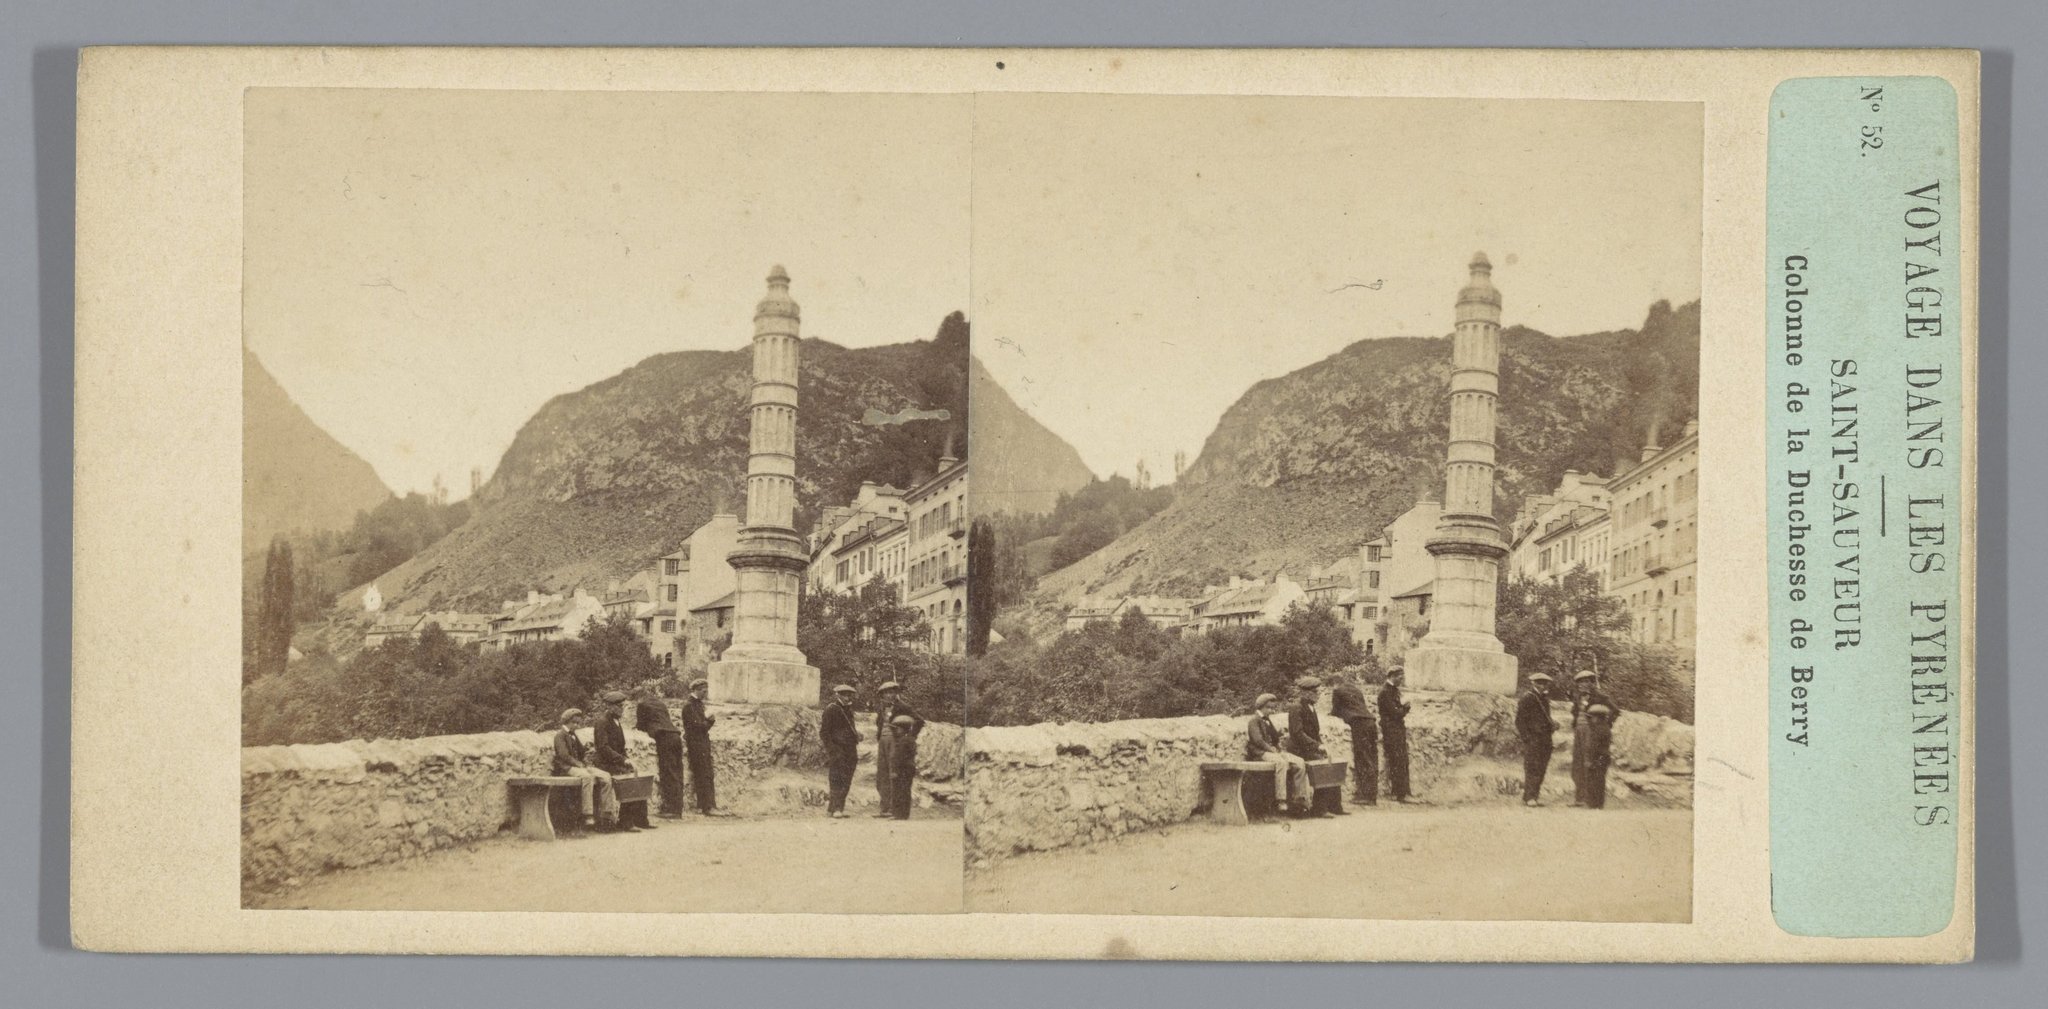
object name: stereograph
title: Saint-Sauveur, Colonne de la Duchess de Berry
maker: charles paul furne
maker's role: publisher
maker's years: 1824-1875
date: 1855-1865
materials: cardboard, photographic support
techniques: albumen print, photography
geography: luz-saint-sauveur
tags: column, pillar ~ architecture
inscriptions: number: ‘No 52.’